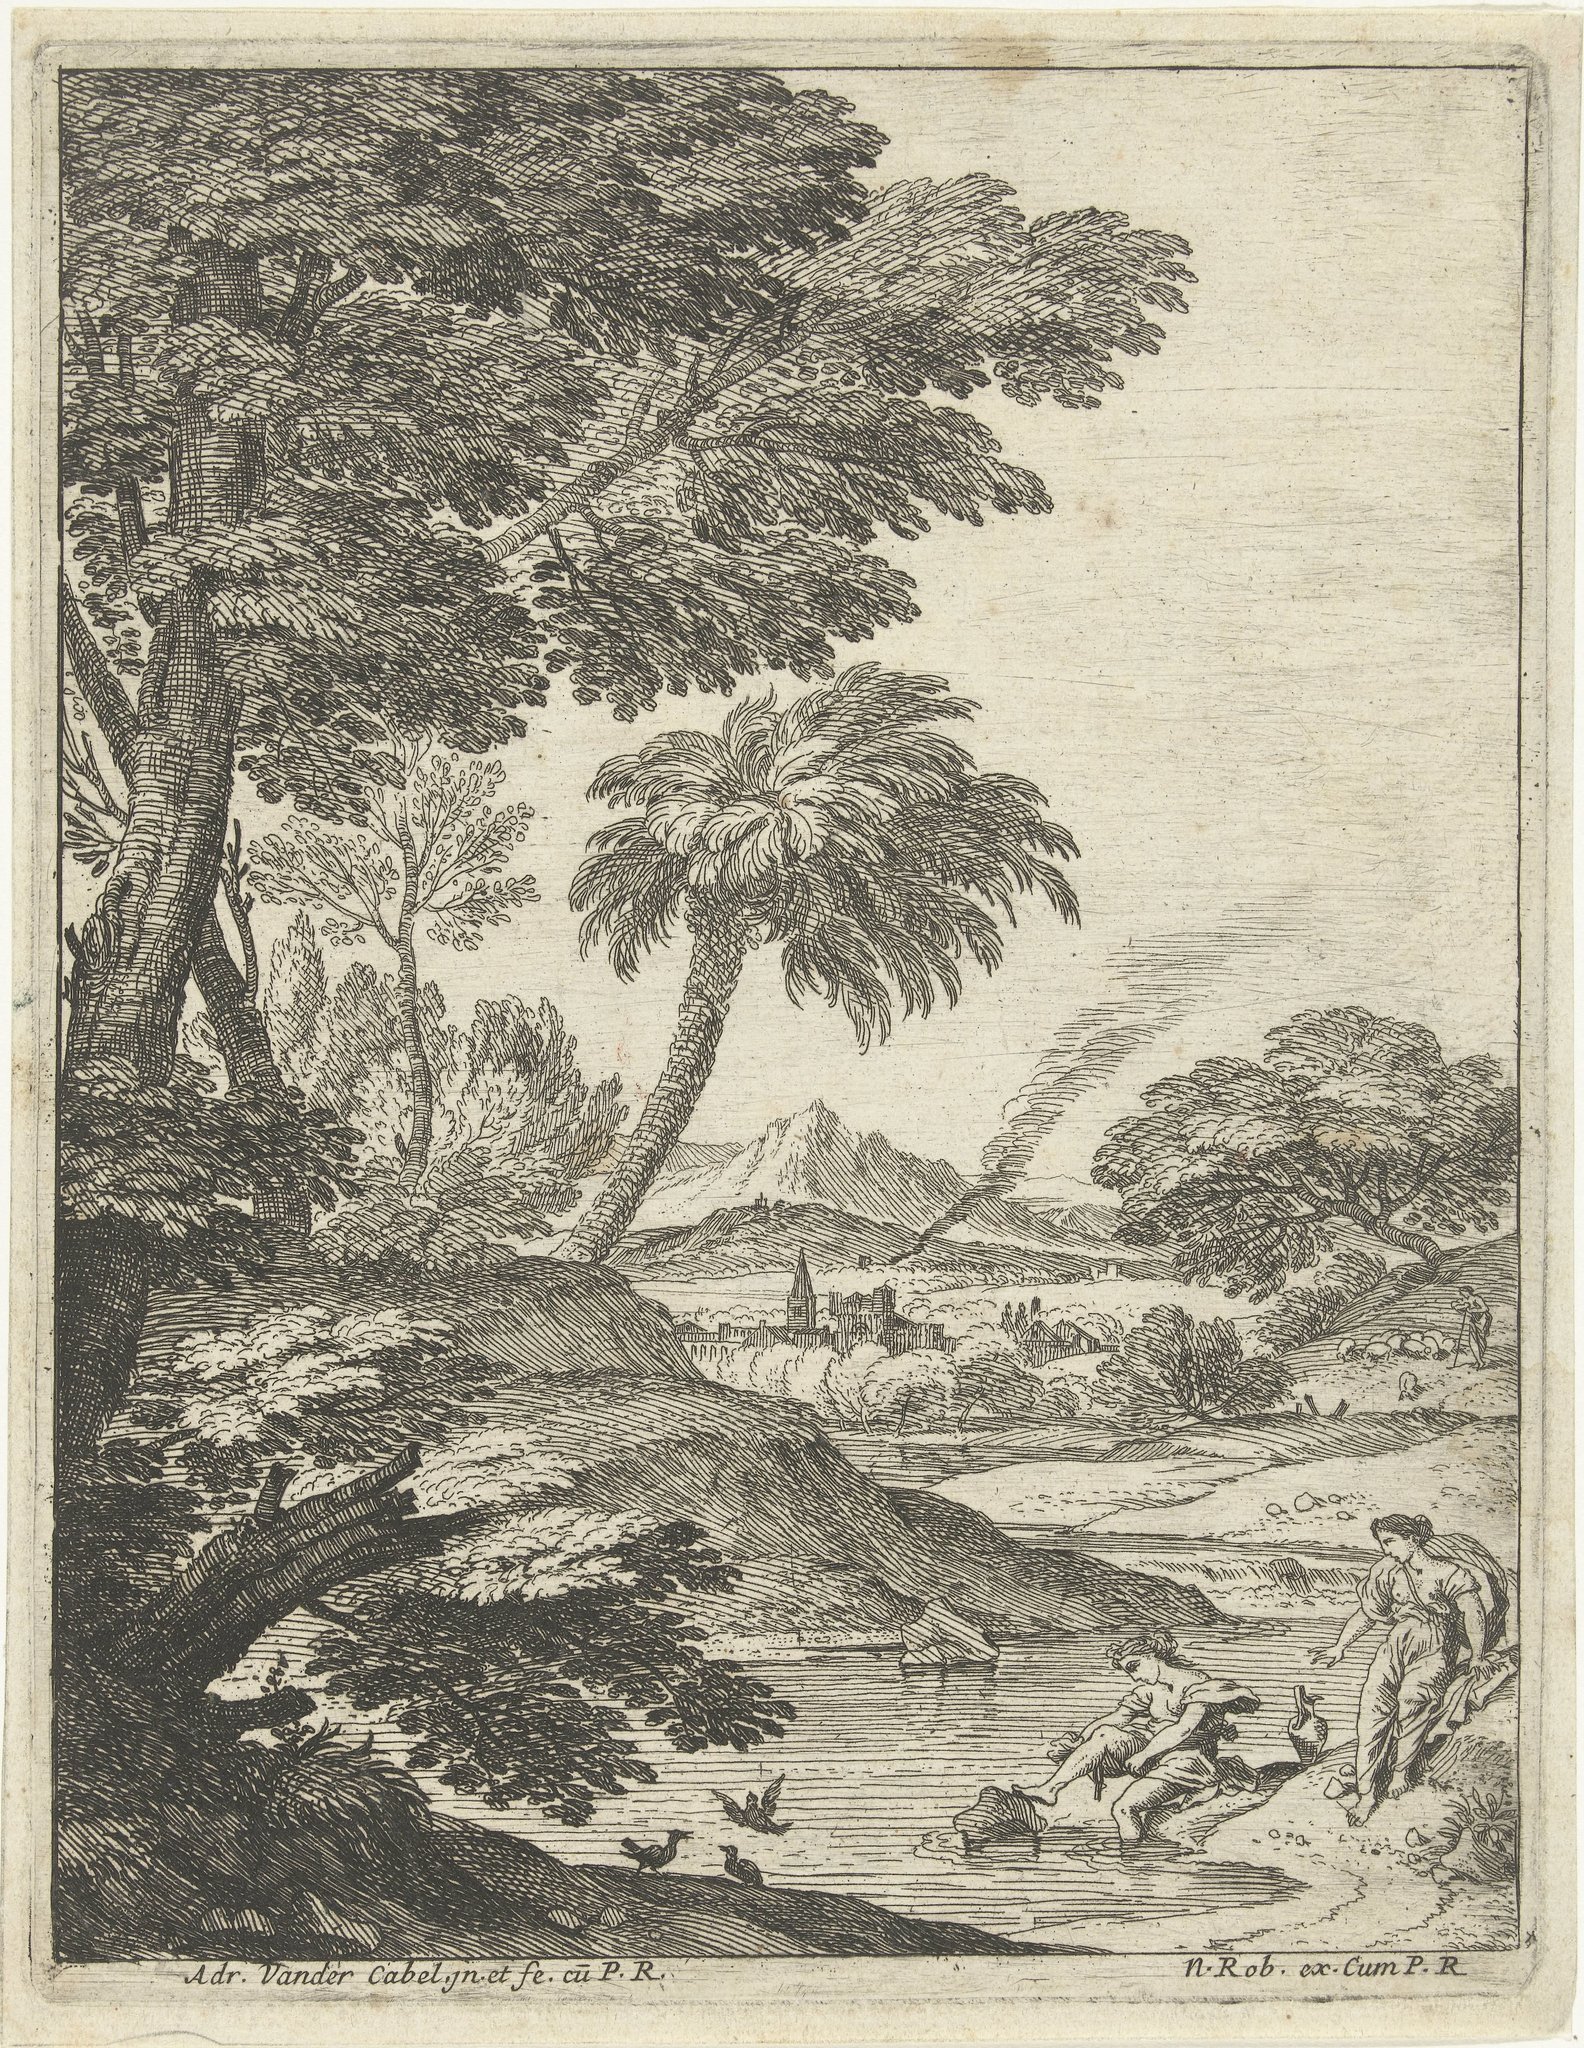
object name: print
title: De badende vrouw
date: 1648-1705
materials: paper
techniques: etching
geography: france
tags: landscapes, herding, herdsman, herdswoman, shepherd, shepherdess, cowherd, etc., washing and bathing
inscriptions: collector's mark: Lugt 2228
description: Landschap met grote bomen; op de voorgrond twee vrouwen bij een rivier, op de achtergrond een schaapsherder en uitzicht op een stad. Tweede prent uit de serie van zes.